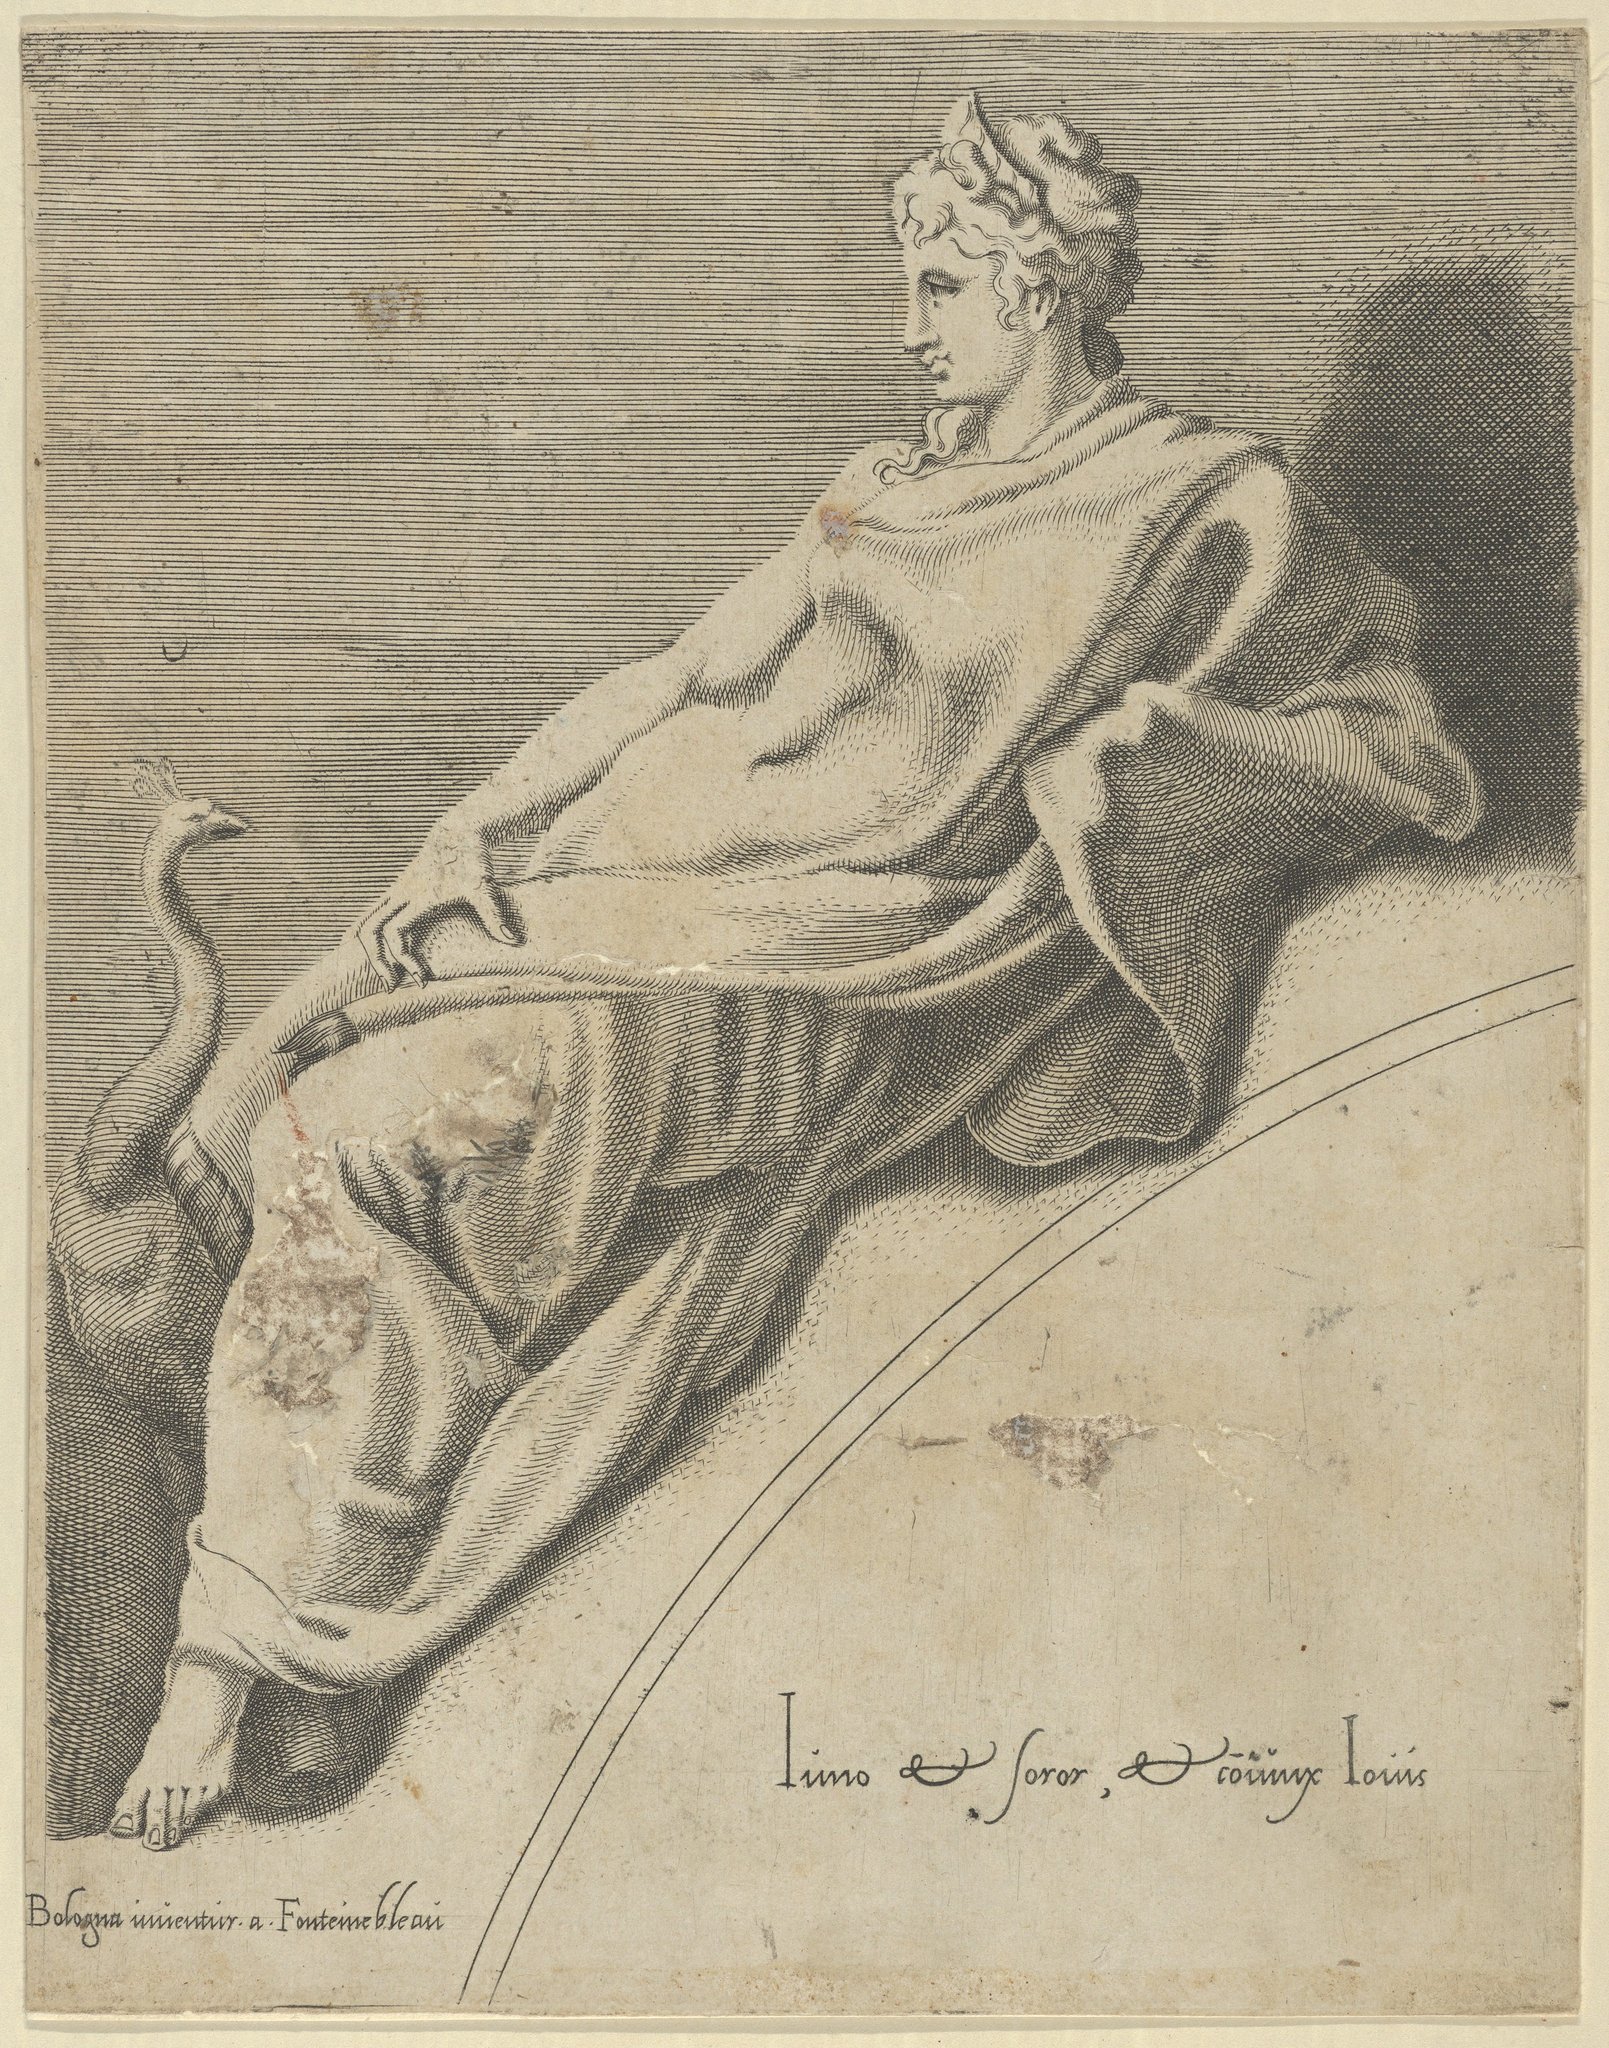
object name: print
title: Juno, from "The Muses and the Three Great Goddesses"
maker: anonymous, italian, 16th century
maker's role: artist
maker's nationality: italian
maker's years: 1550-1600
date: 1540-1556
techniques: engraving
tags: juno,peacocks,goddess